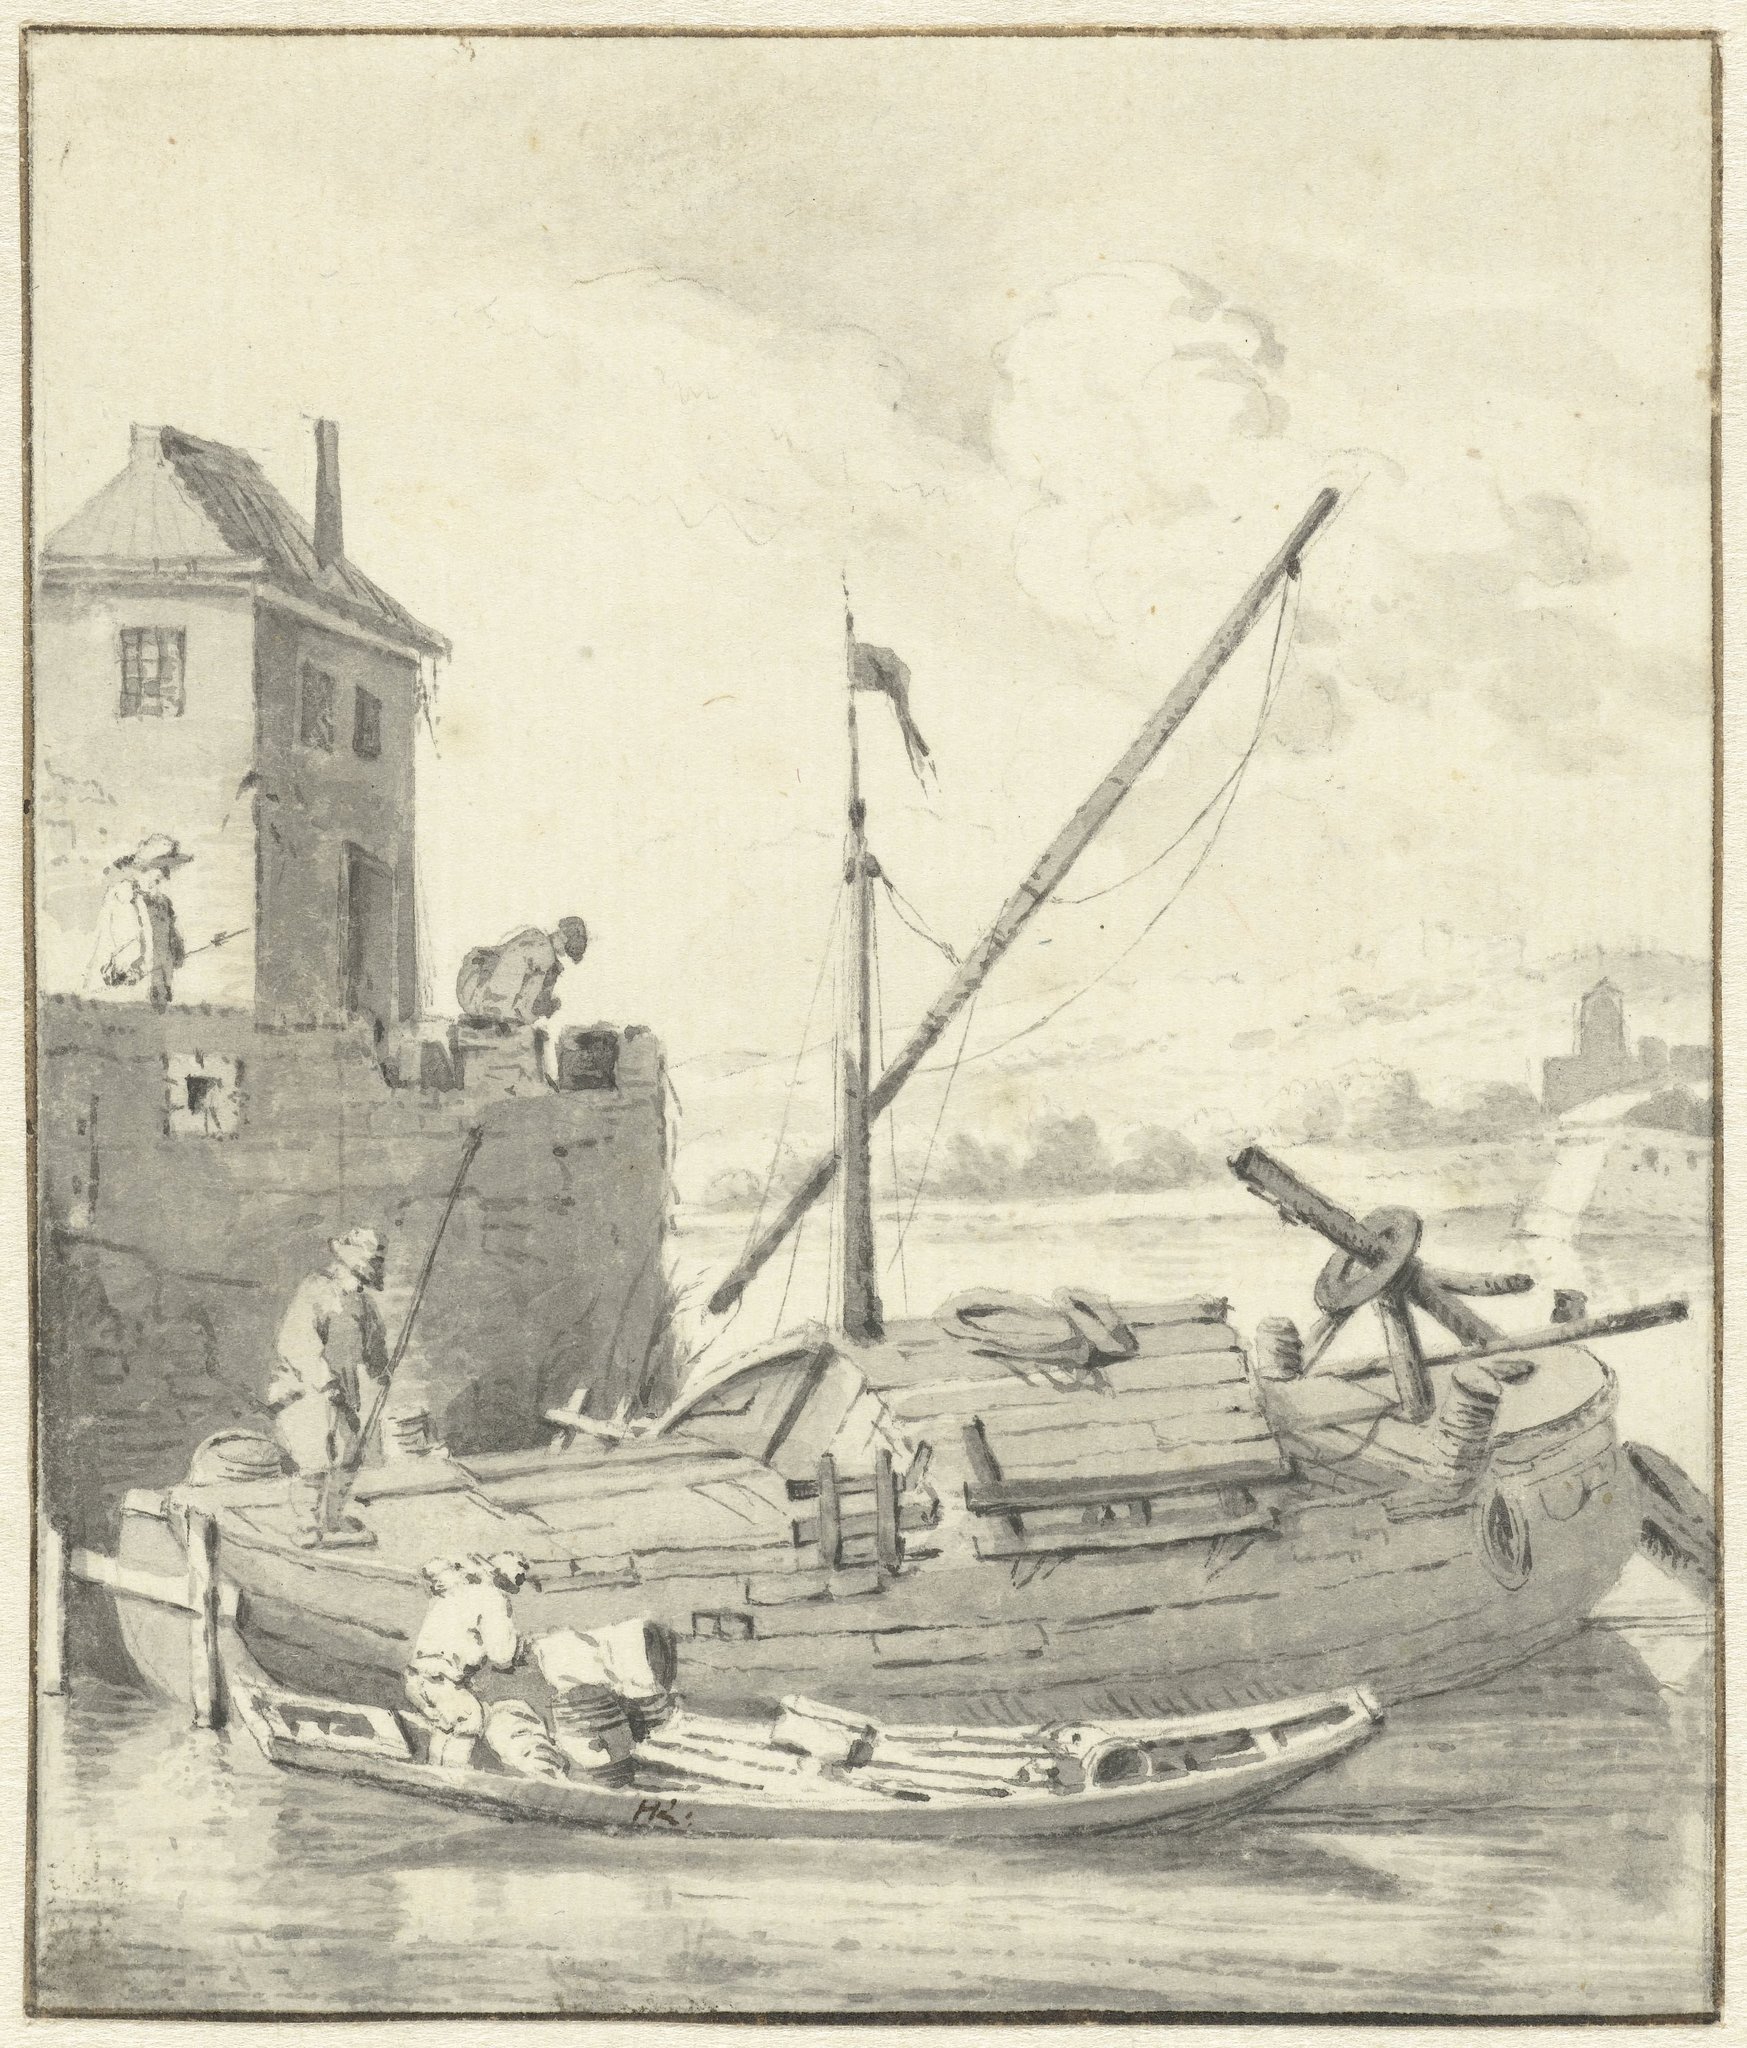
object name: drawing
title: Schuit bij een stadsmuur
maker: hendrik rietschoof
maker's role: draughtsman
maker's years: 1678-1746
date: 1697-1746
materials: ink, paper, pencil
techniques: brush, pen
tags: sailing-ship, sailing-boat